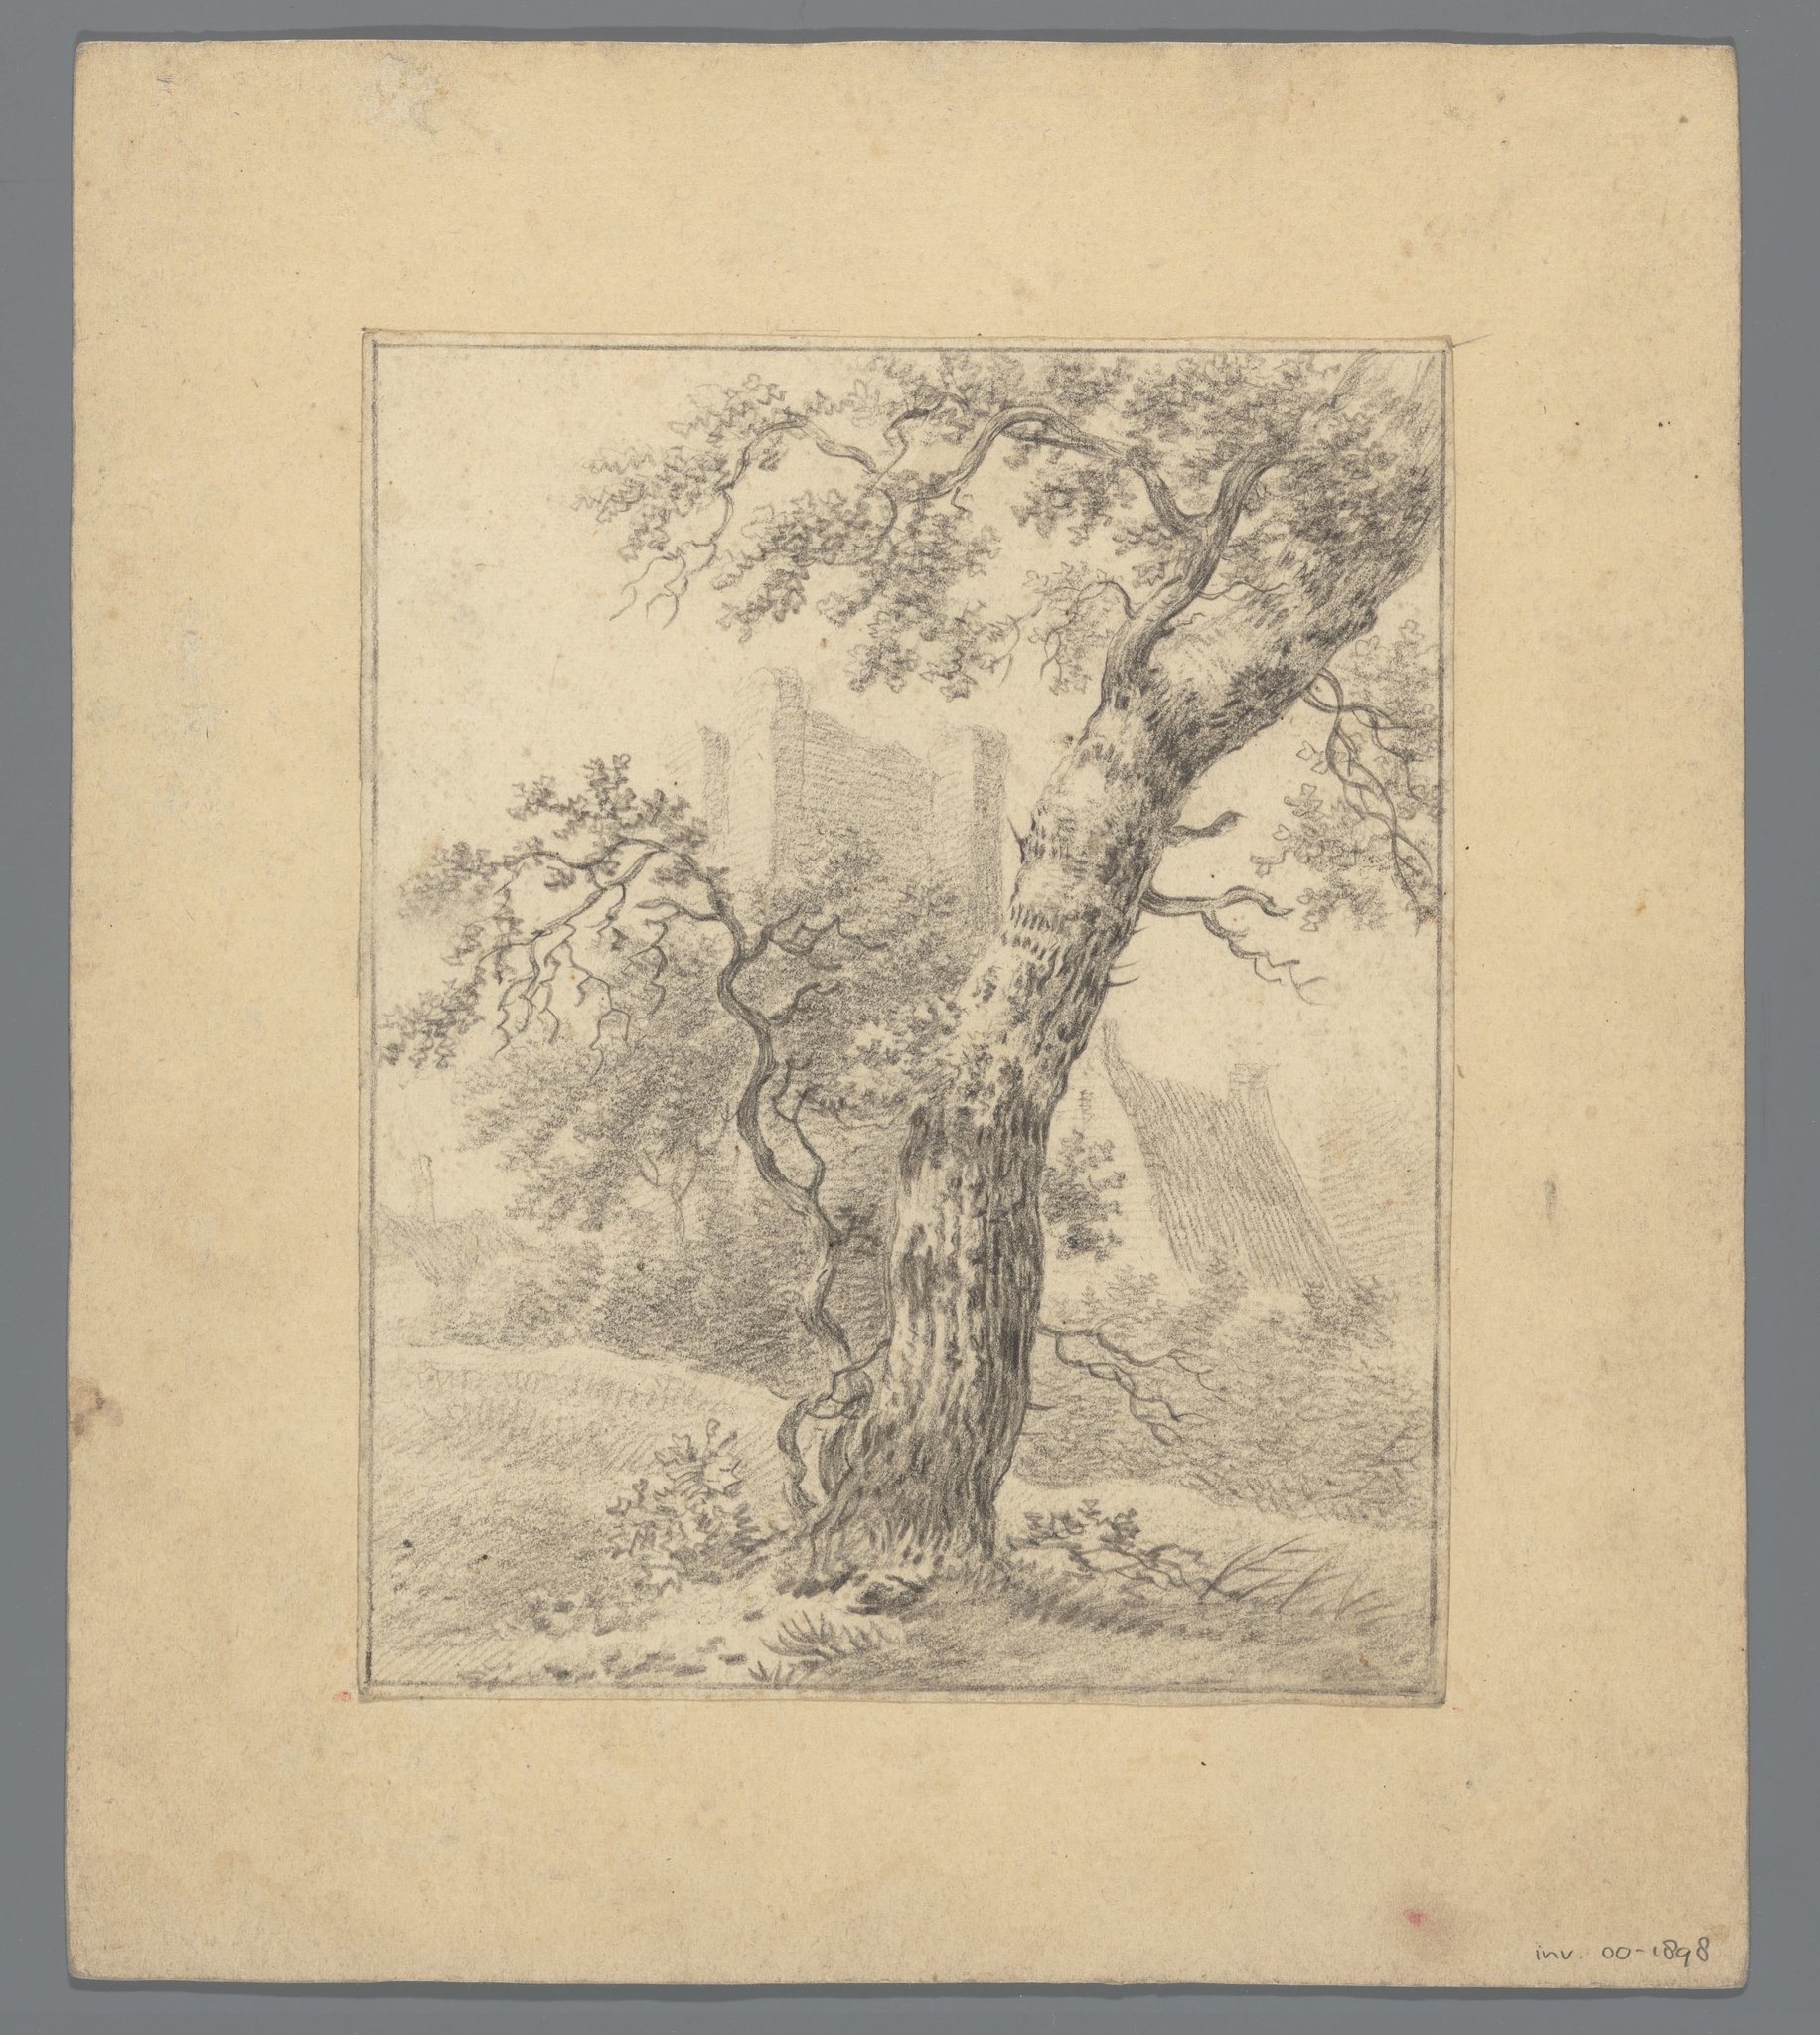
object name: drawing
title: Landschap met boom op voorgrond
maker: Anonymous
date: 1700-1800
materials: chalk, paper